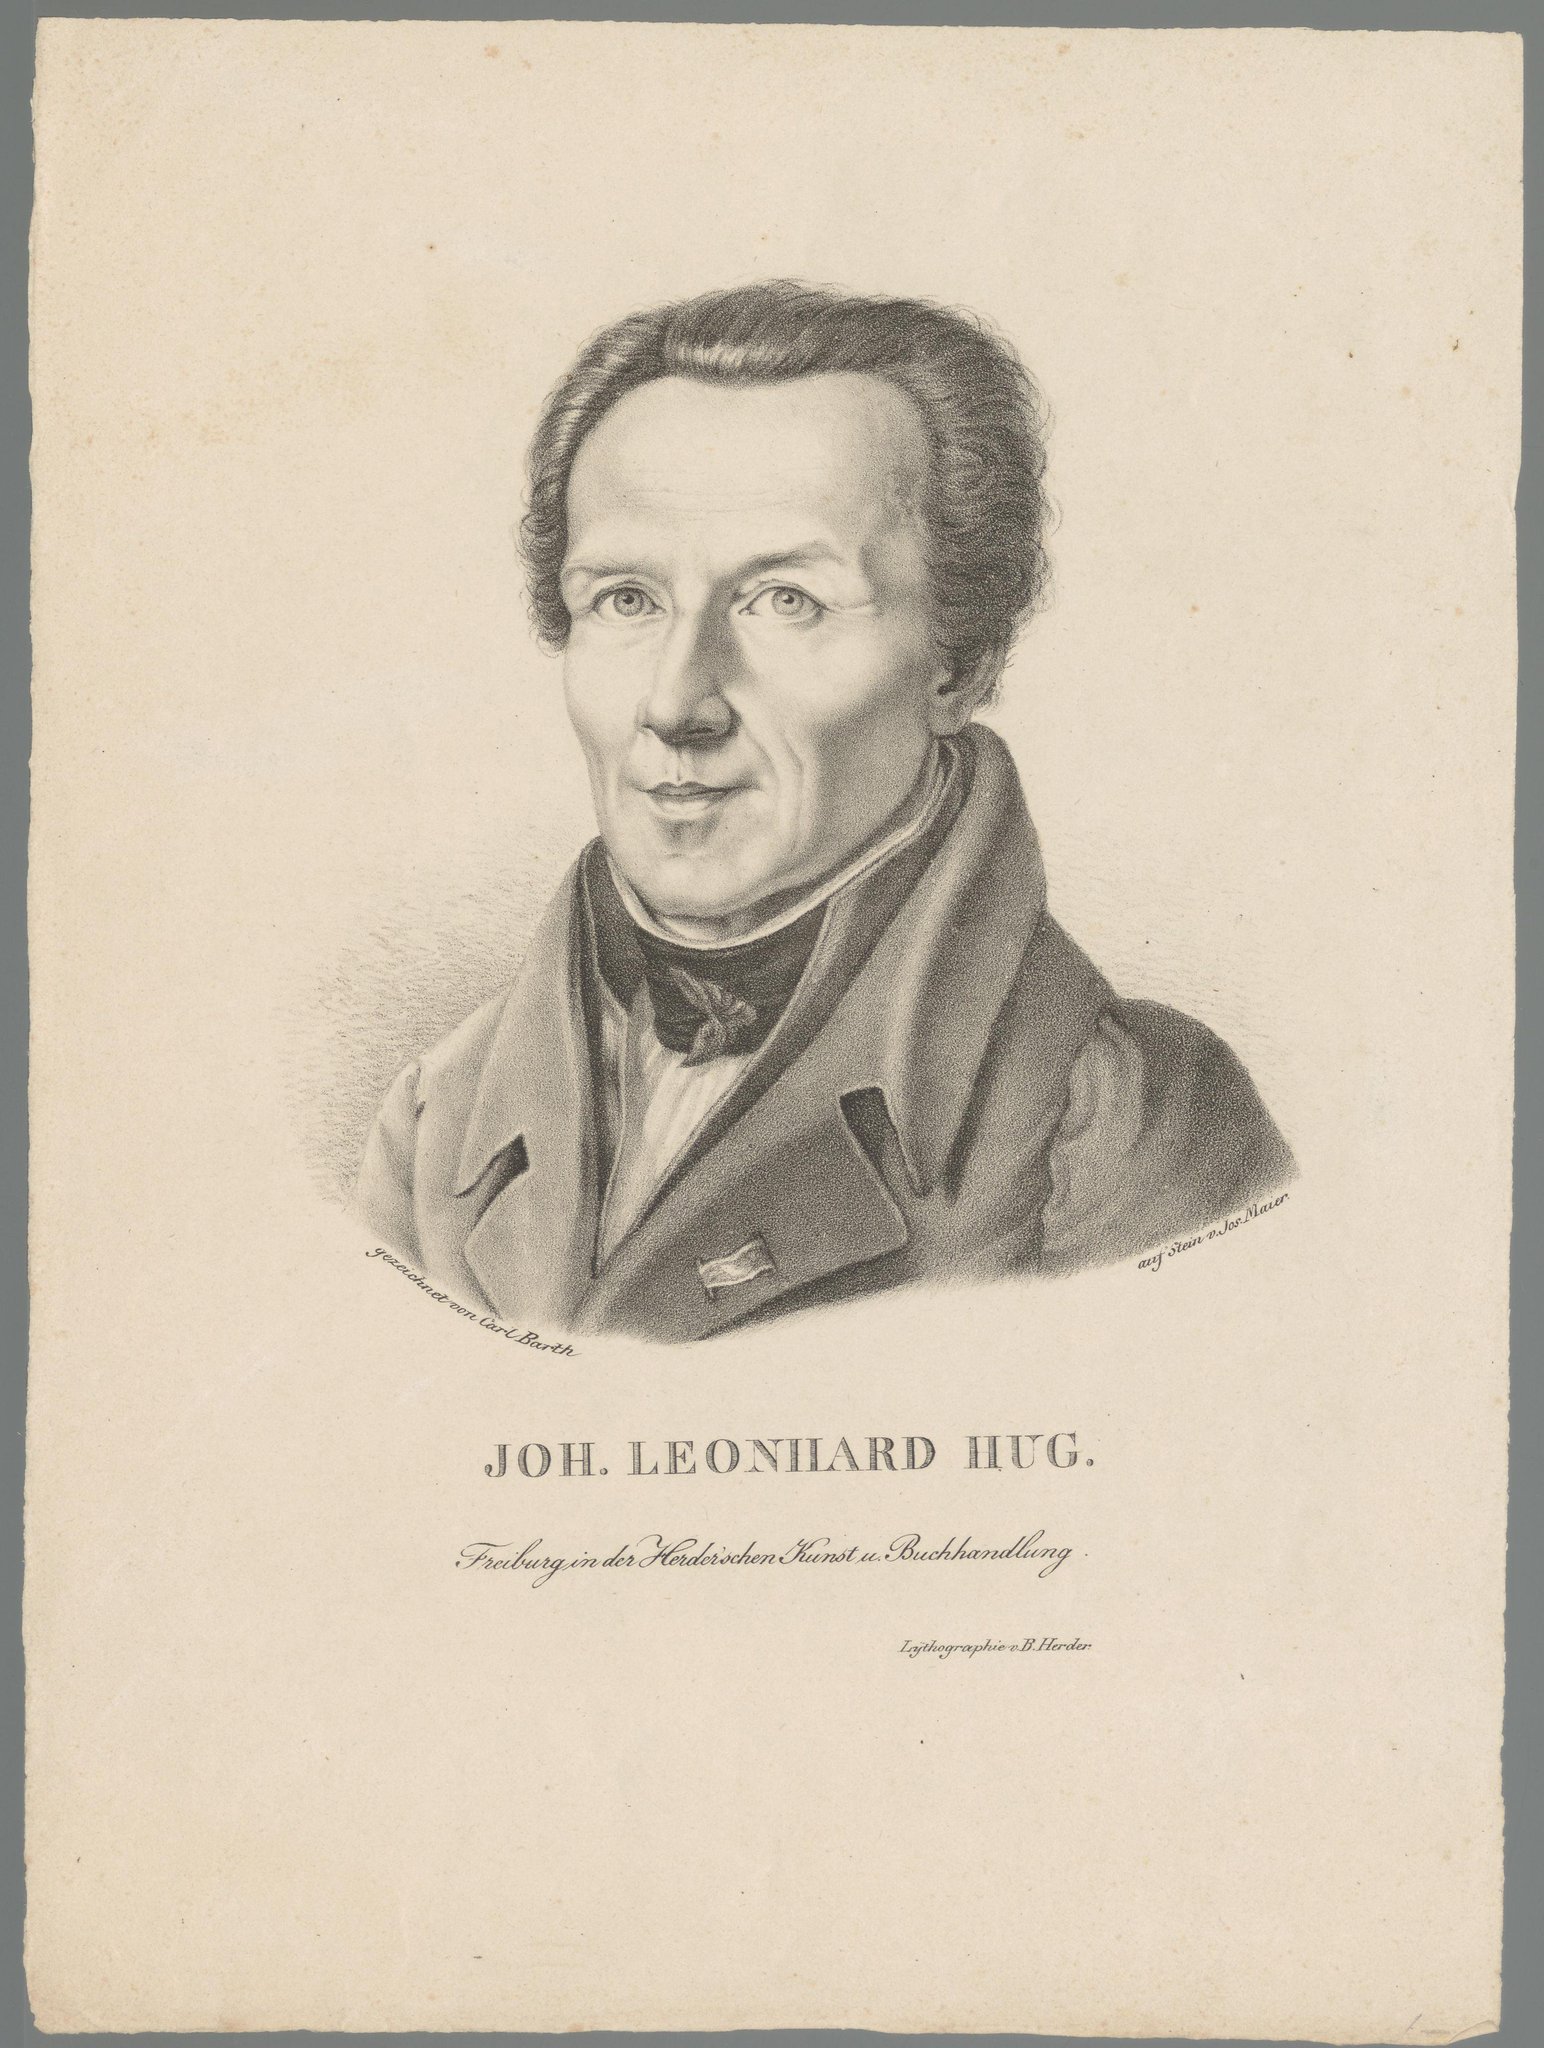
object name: print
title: Joh. Leonhard Hug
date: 1818-1880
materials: paper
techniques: lithograph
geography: freiburg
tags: theologian, historical persons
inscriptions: collector's mark: Lugt 2228